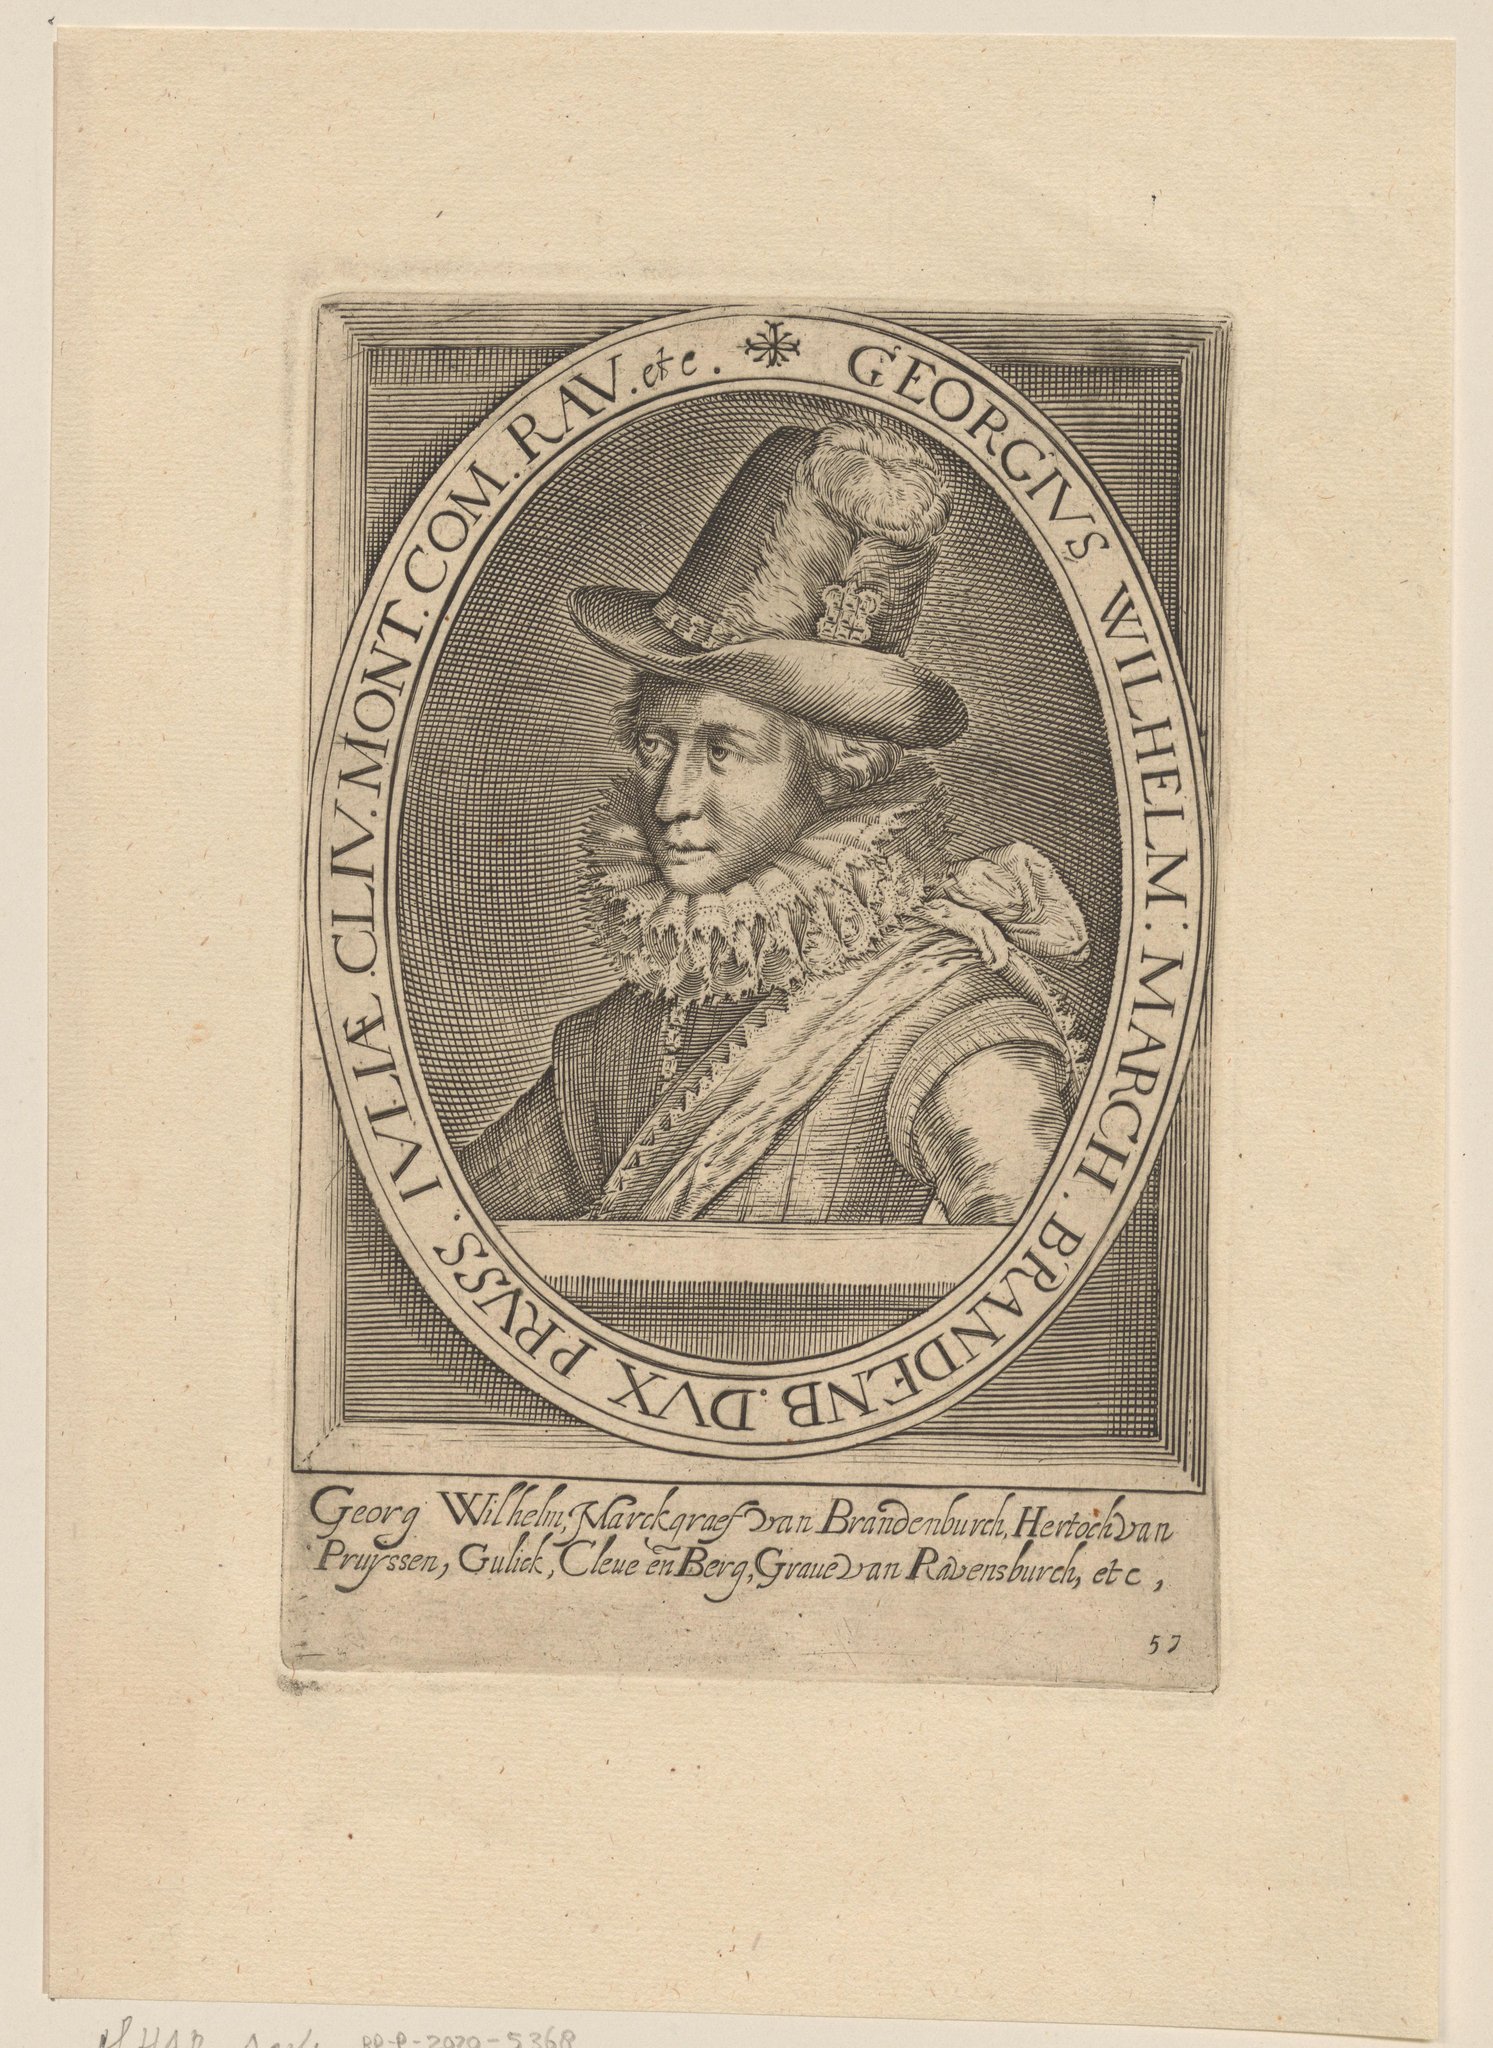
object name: print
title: Portret van Georg Wilhelm van Brandenburg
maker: nicolaes de clerck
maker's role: publisher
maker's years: 1569-1623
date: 1579-1625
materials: paper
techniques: engraving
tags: historical persons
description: Eerdere staat van prent gebruikt in: Clerck, Nicolaes de. Princelyck cabinet: verthoonende t'leven afcomste ende afbeeldingen der voornaemste vorste[n] princes graven en[de] heeren van Europa (...). [Delft]: erven Nicolaes de Clerck, 1625, p. 53.